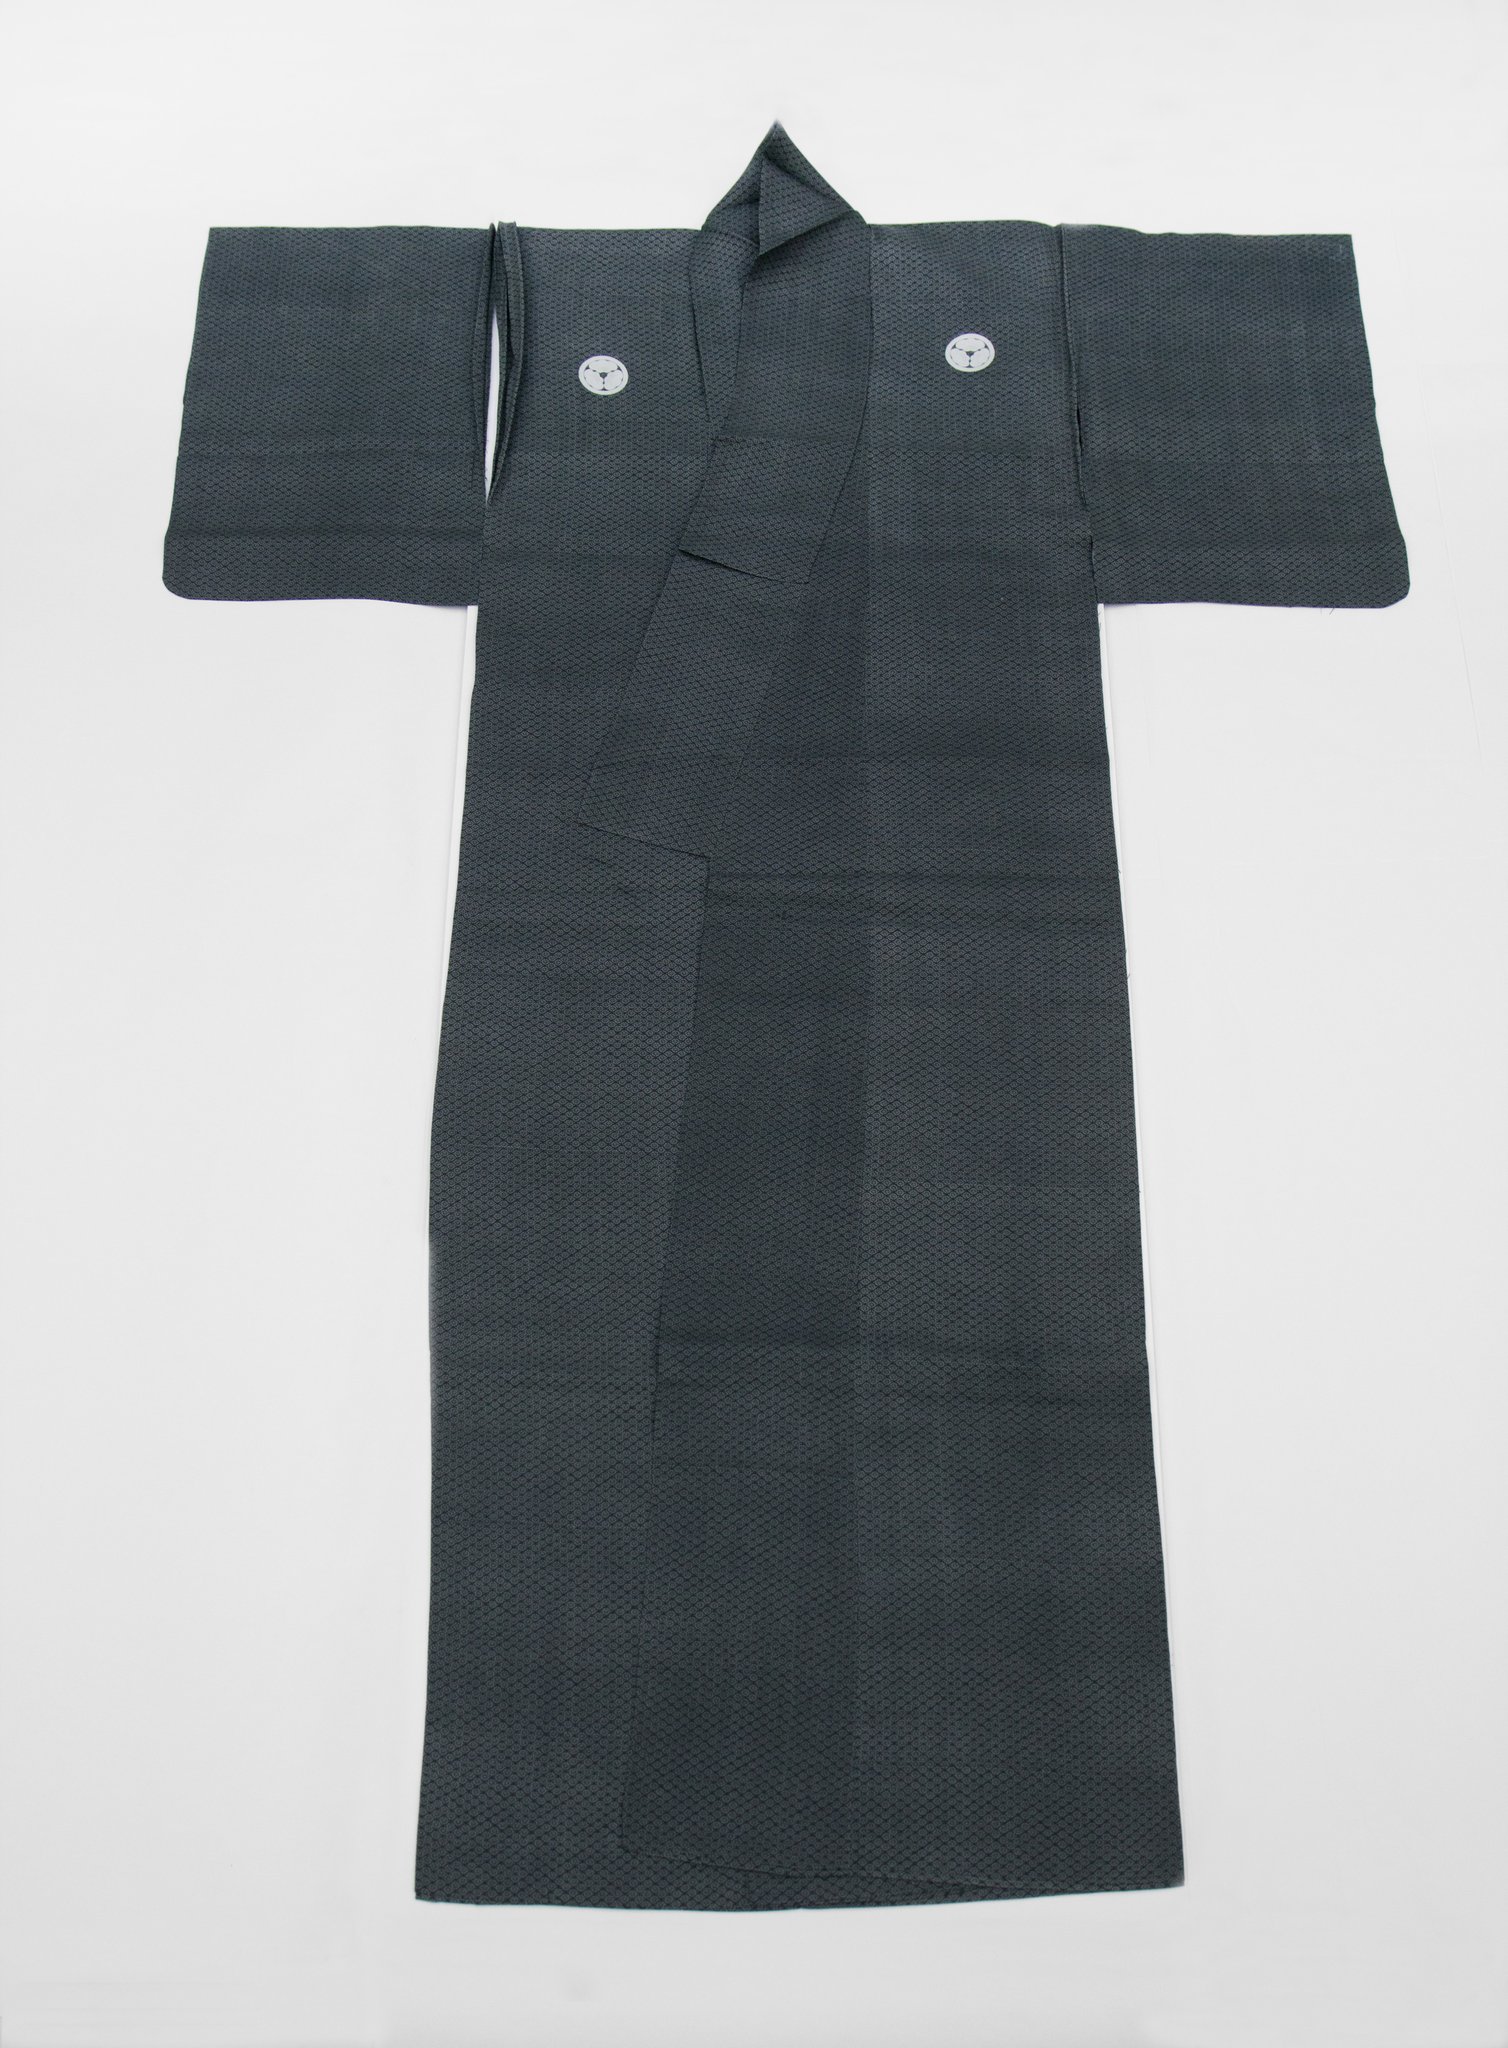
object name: kosode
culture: japanese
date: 1701-1900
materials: silk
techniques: dyeing, weave